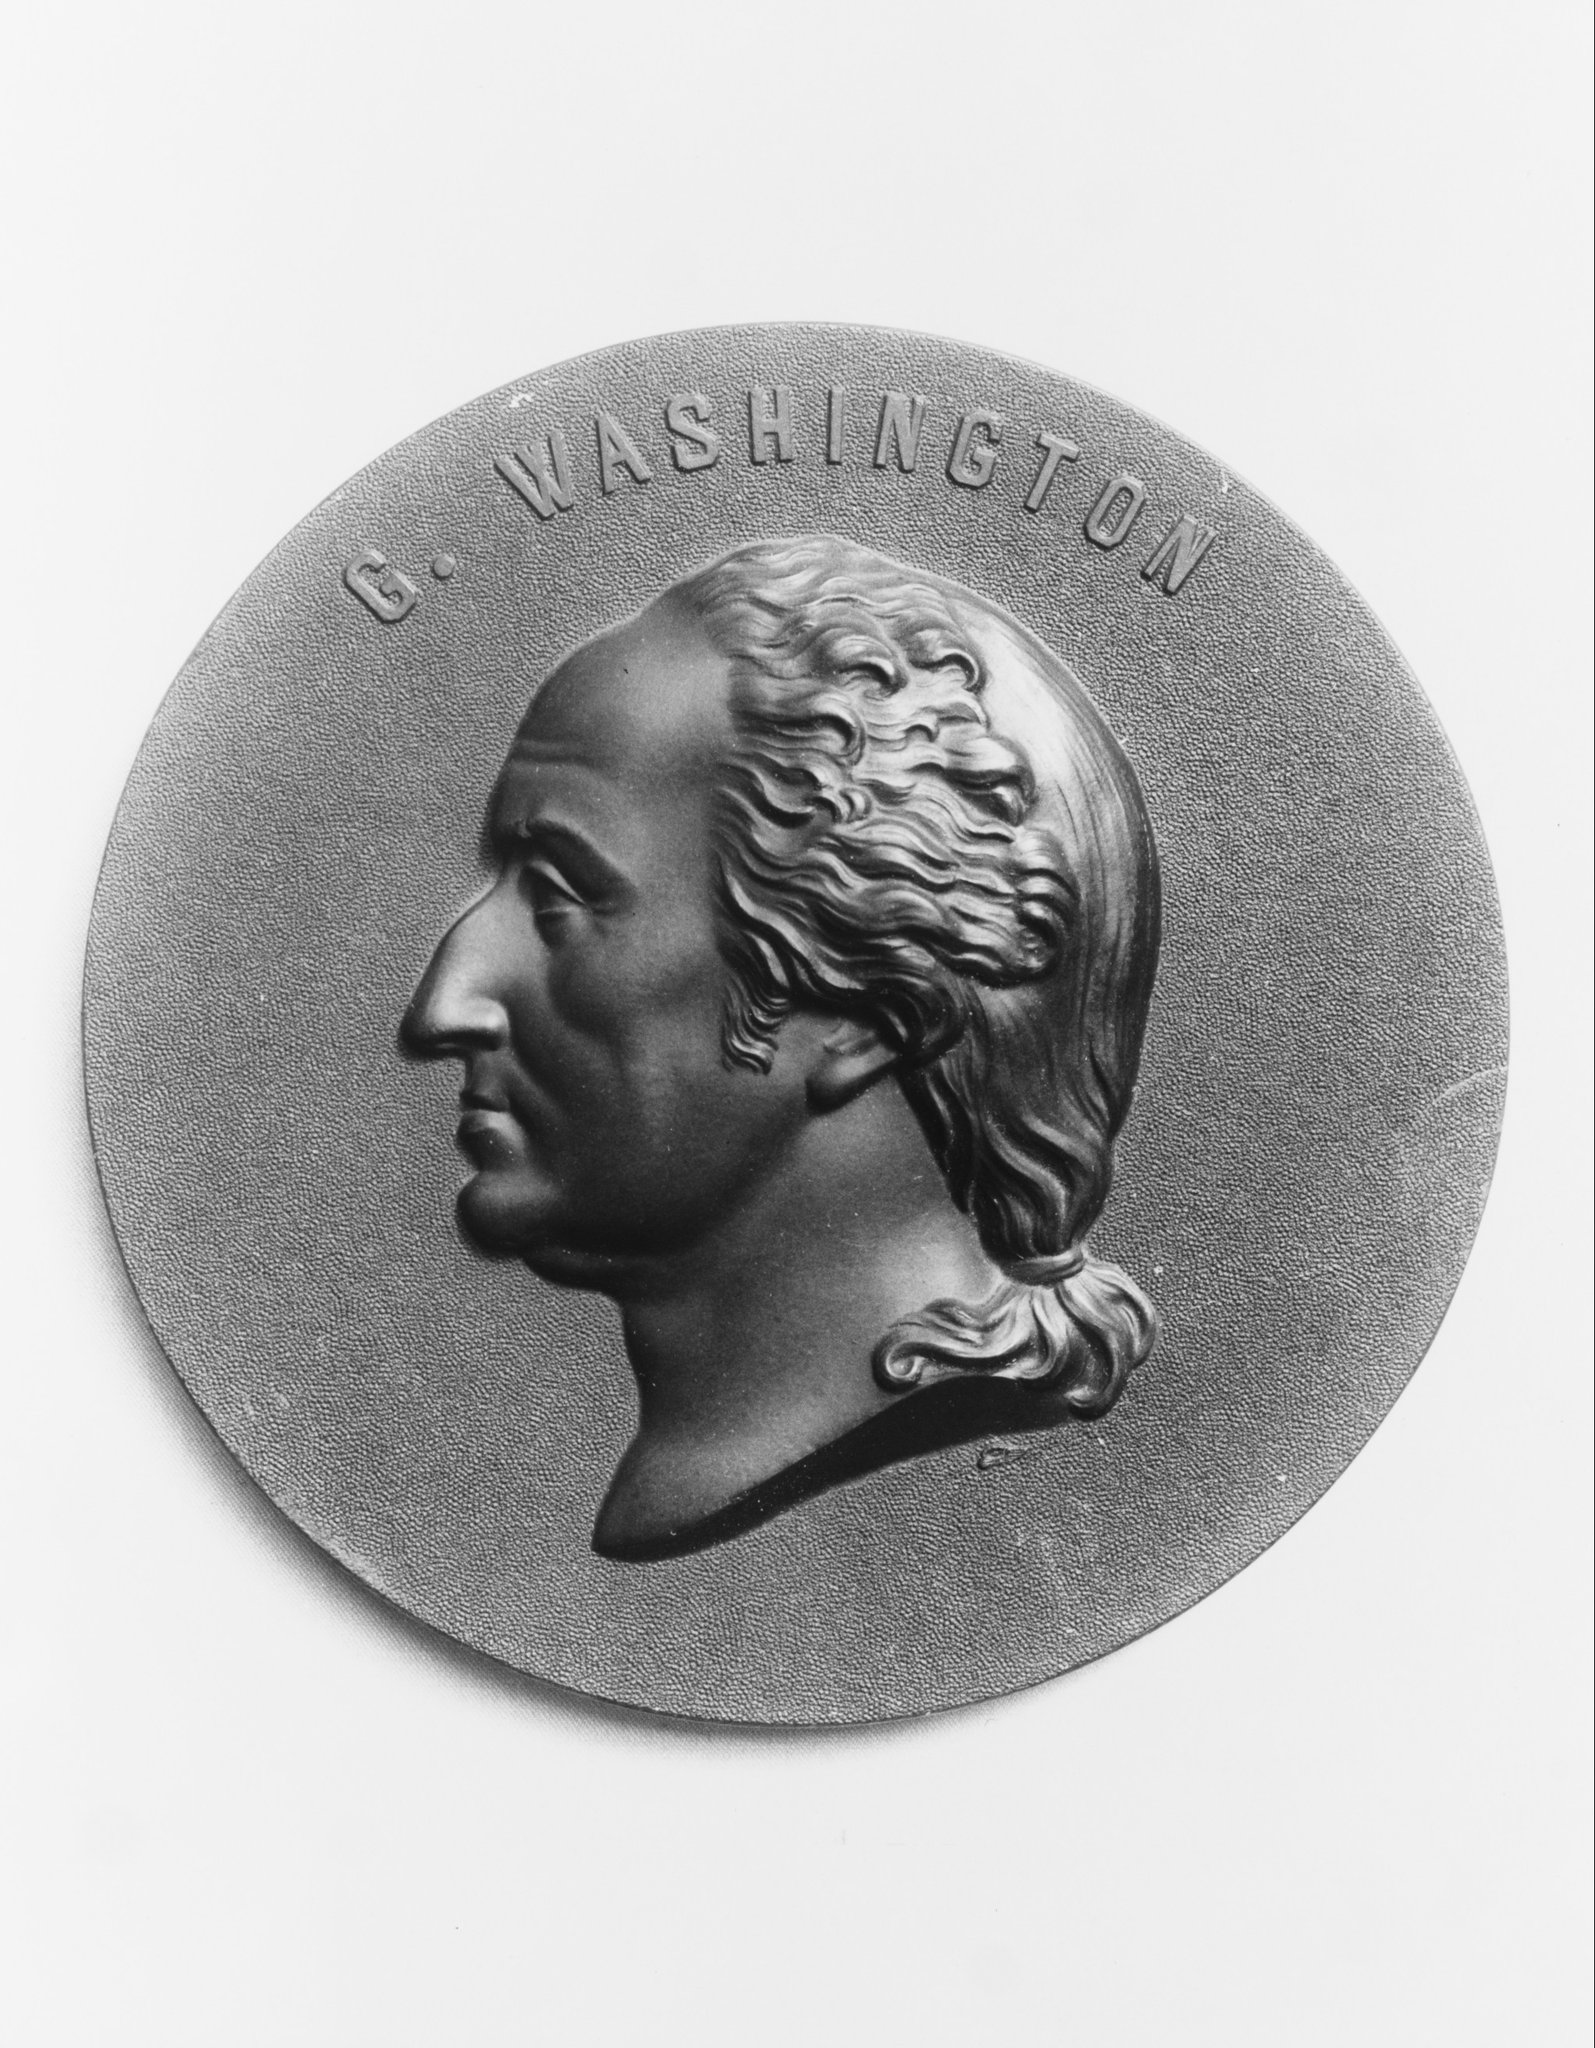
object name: plaque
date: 1859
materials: wood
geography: france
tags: george washington,profiles